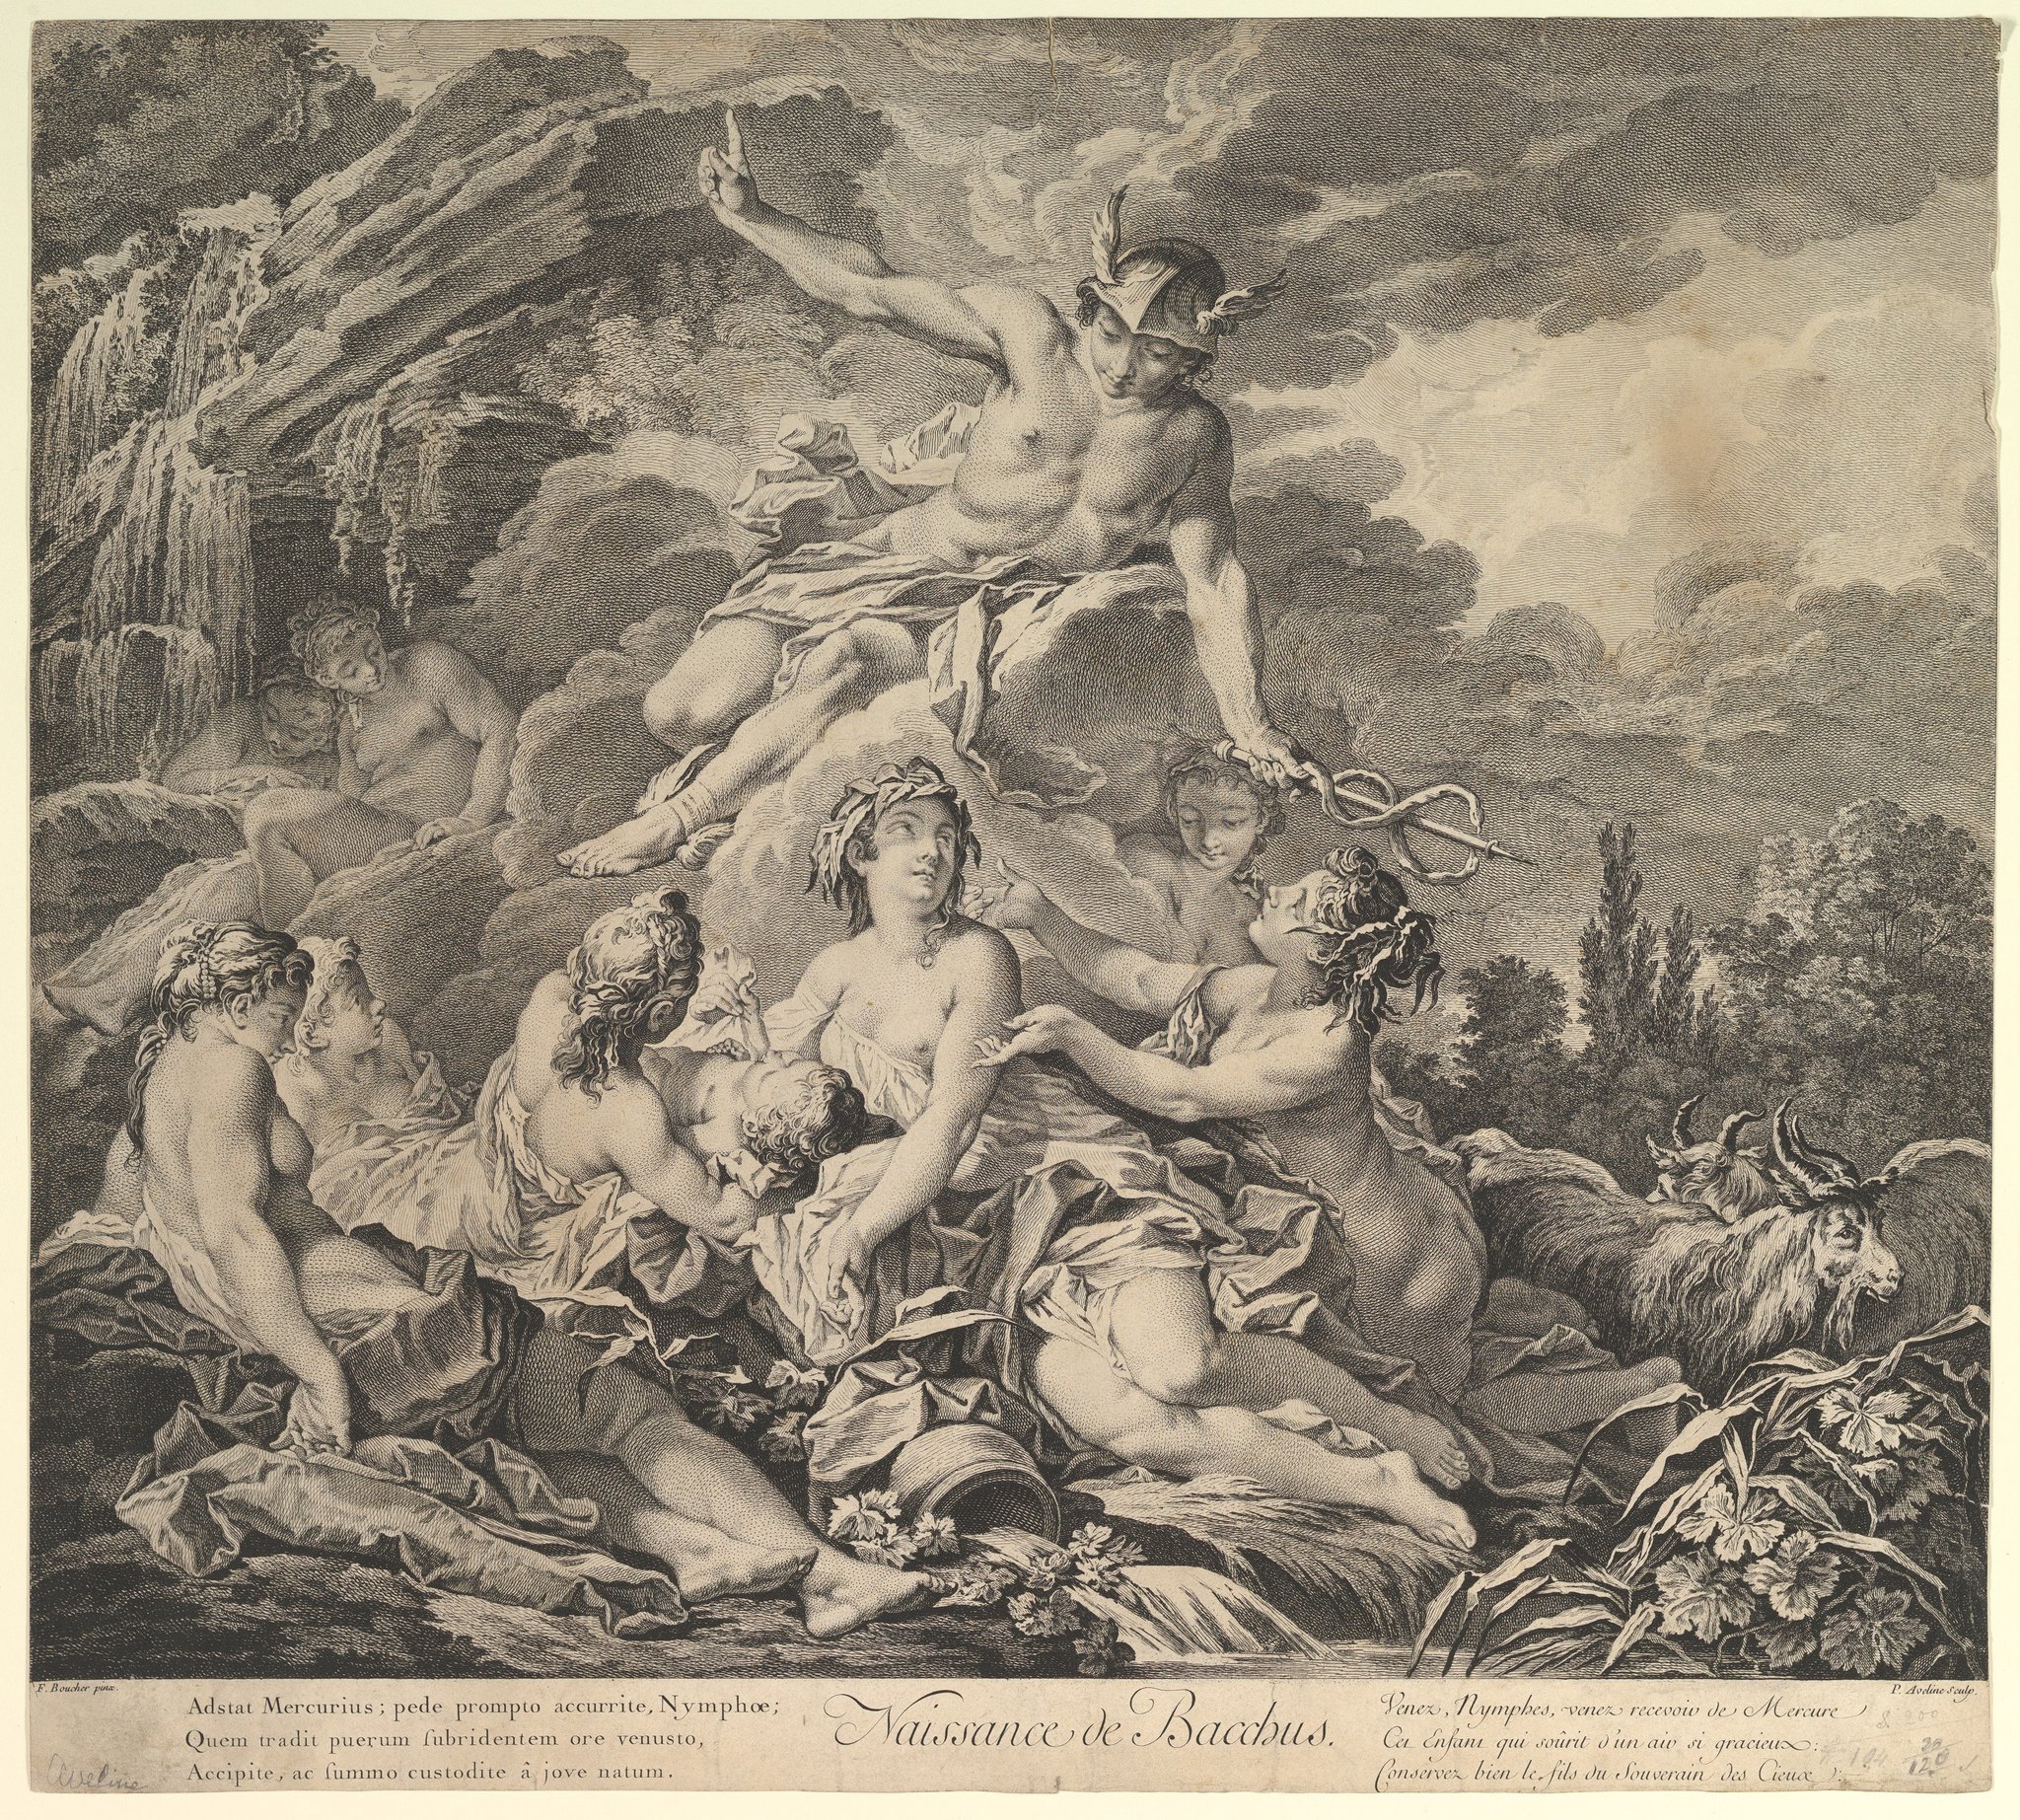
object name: print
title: Naissance de Bacchus (Birth of Bacchus)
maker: pierre alexandre aveline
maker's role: artist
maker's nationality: french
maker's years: 1702-1760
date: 1701-1800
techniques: engraving, etching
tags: animals,female nudes,bacchus,birth